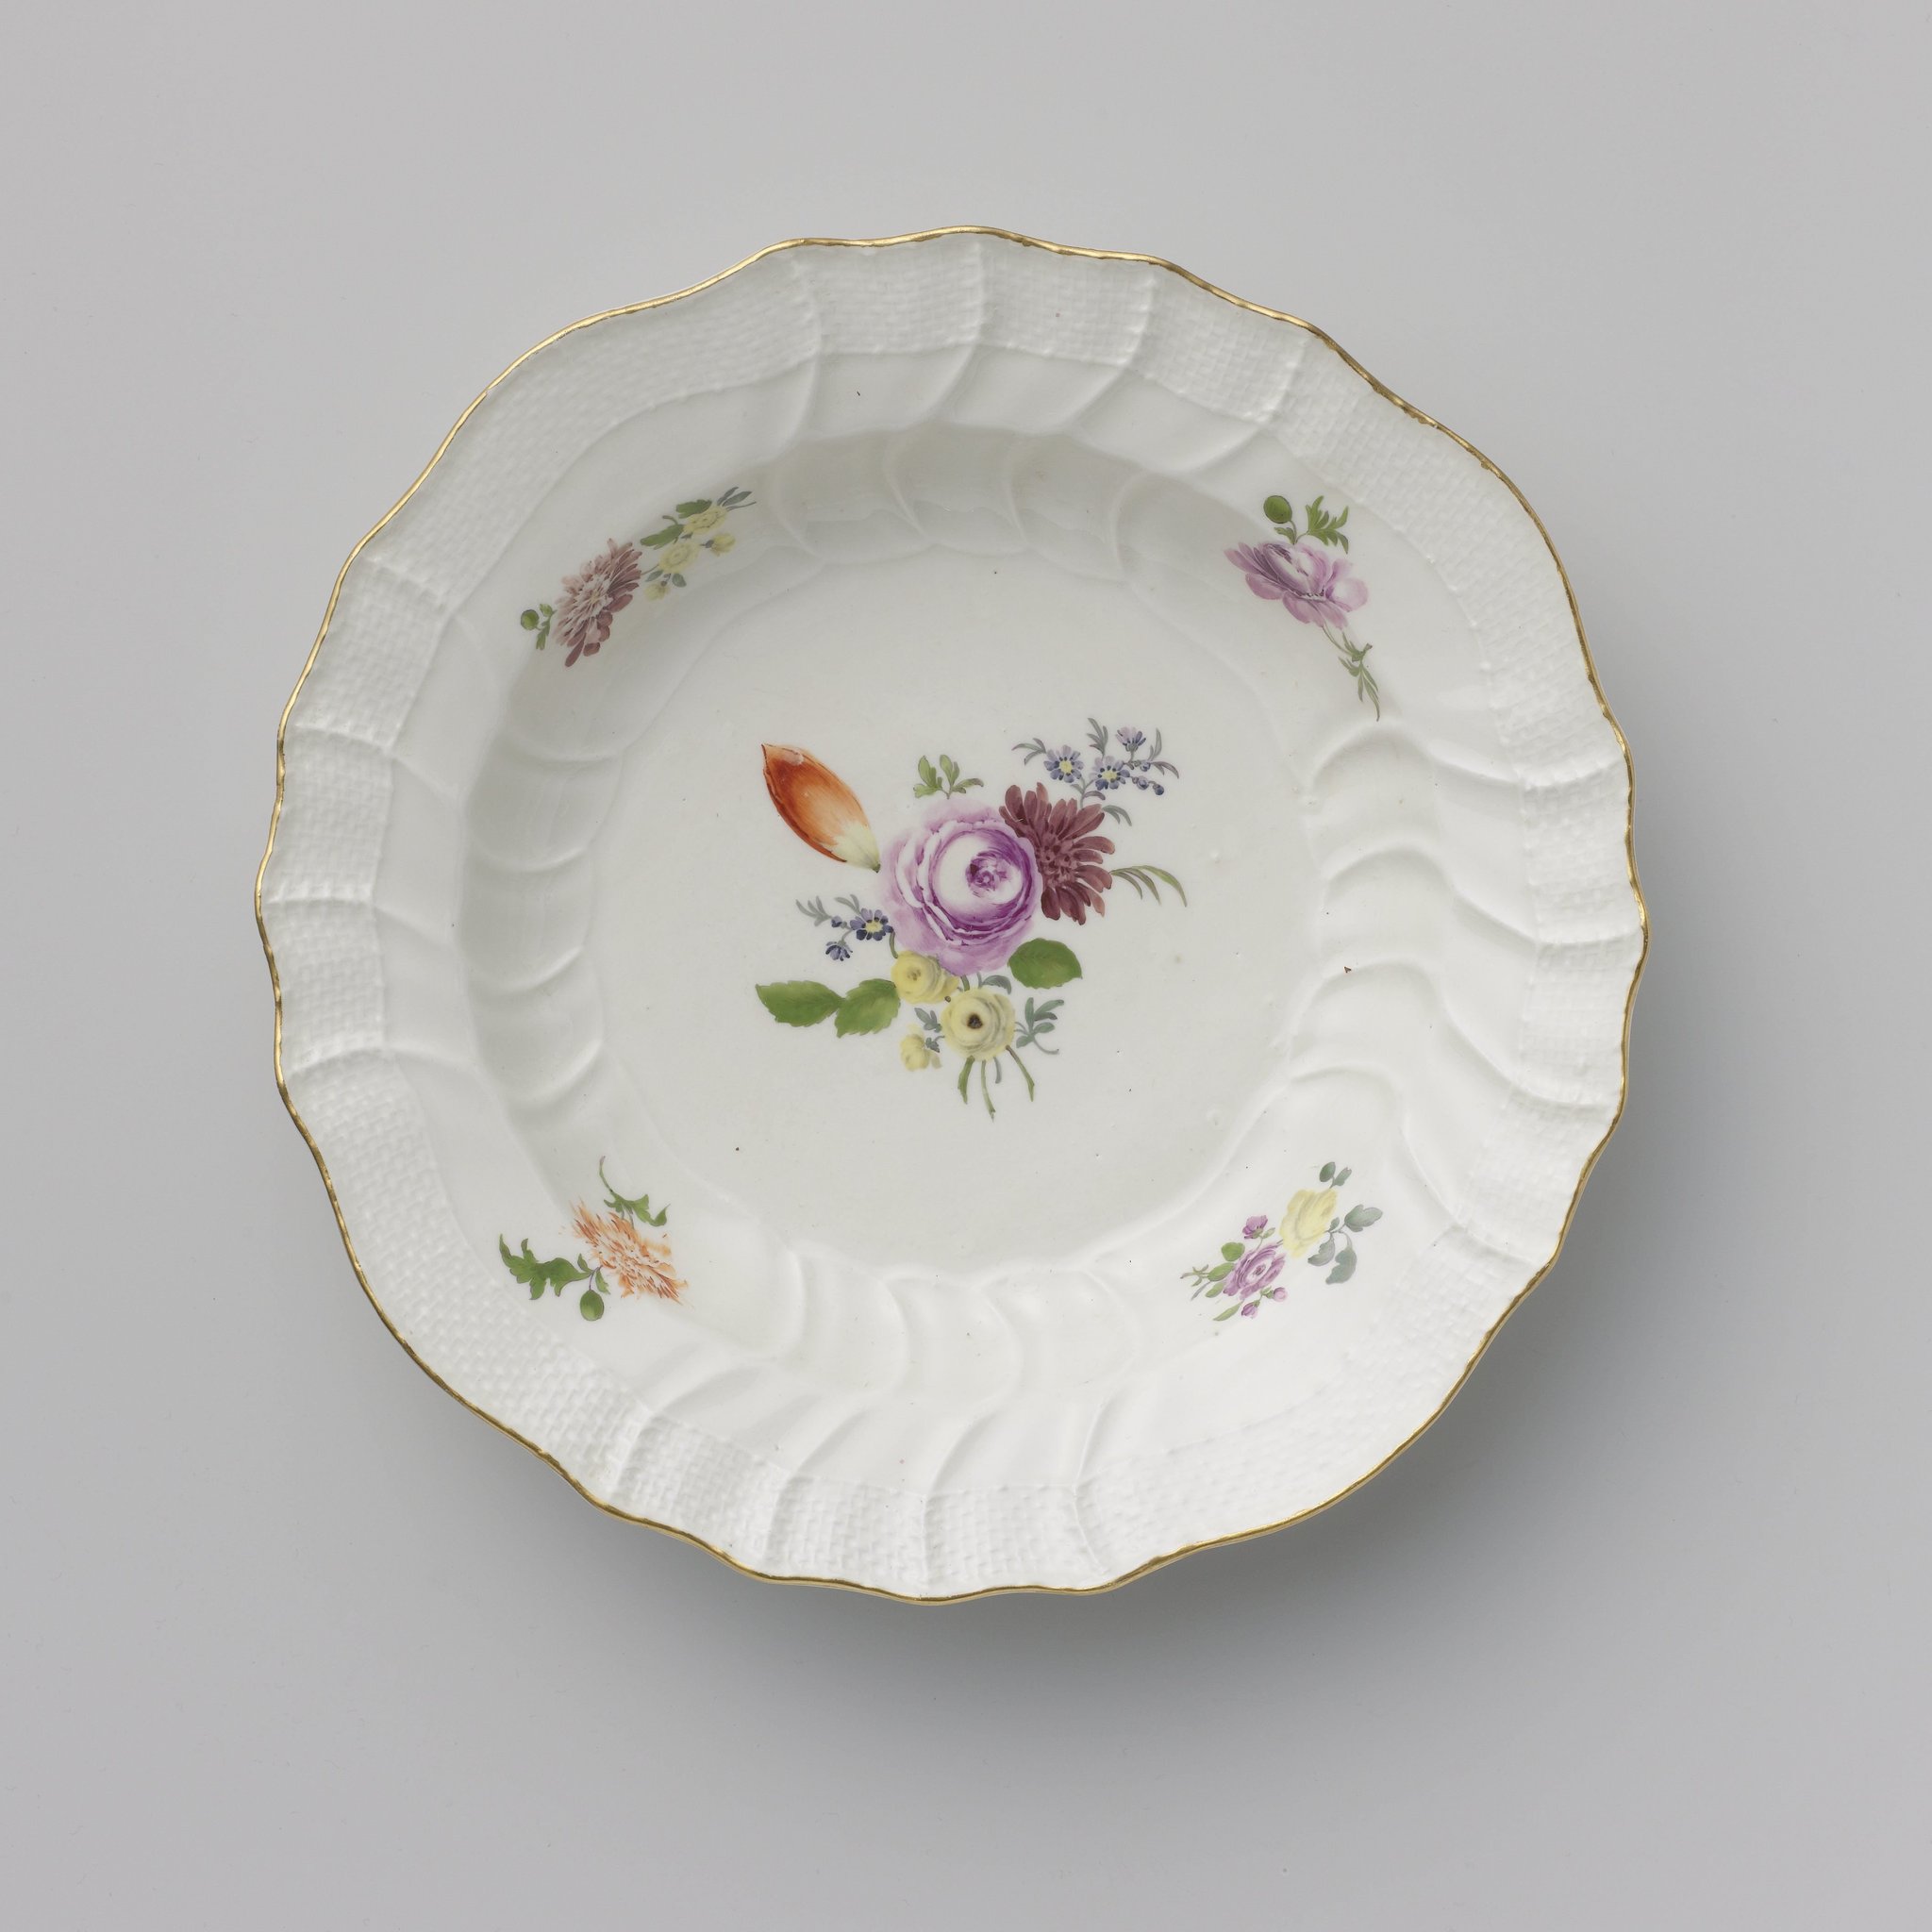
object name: eating drinking utensil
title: Bord, veelkleurig beschilderd met Deutsche Blumen, insekten en vruchten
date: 1750-1760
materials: porcelain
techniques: painted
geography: meissen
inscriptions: factory mark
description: Rond soepbord van beschilderd porselein. Het bord is beschilderd met Deutsche Blumen, insekten en vruchten. De rand is in reliëf versierd met het Neuozier-patroon. Het bord is gemerkt en hoort bij een servies (BK-17474-1 t/m BK-17474-253).